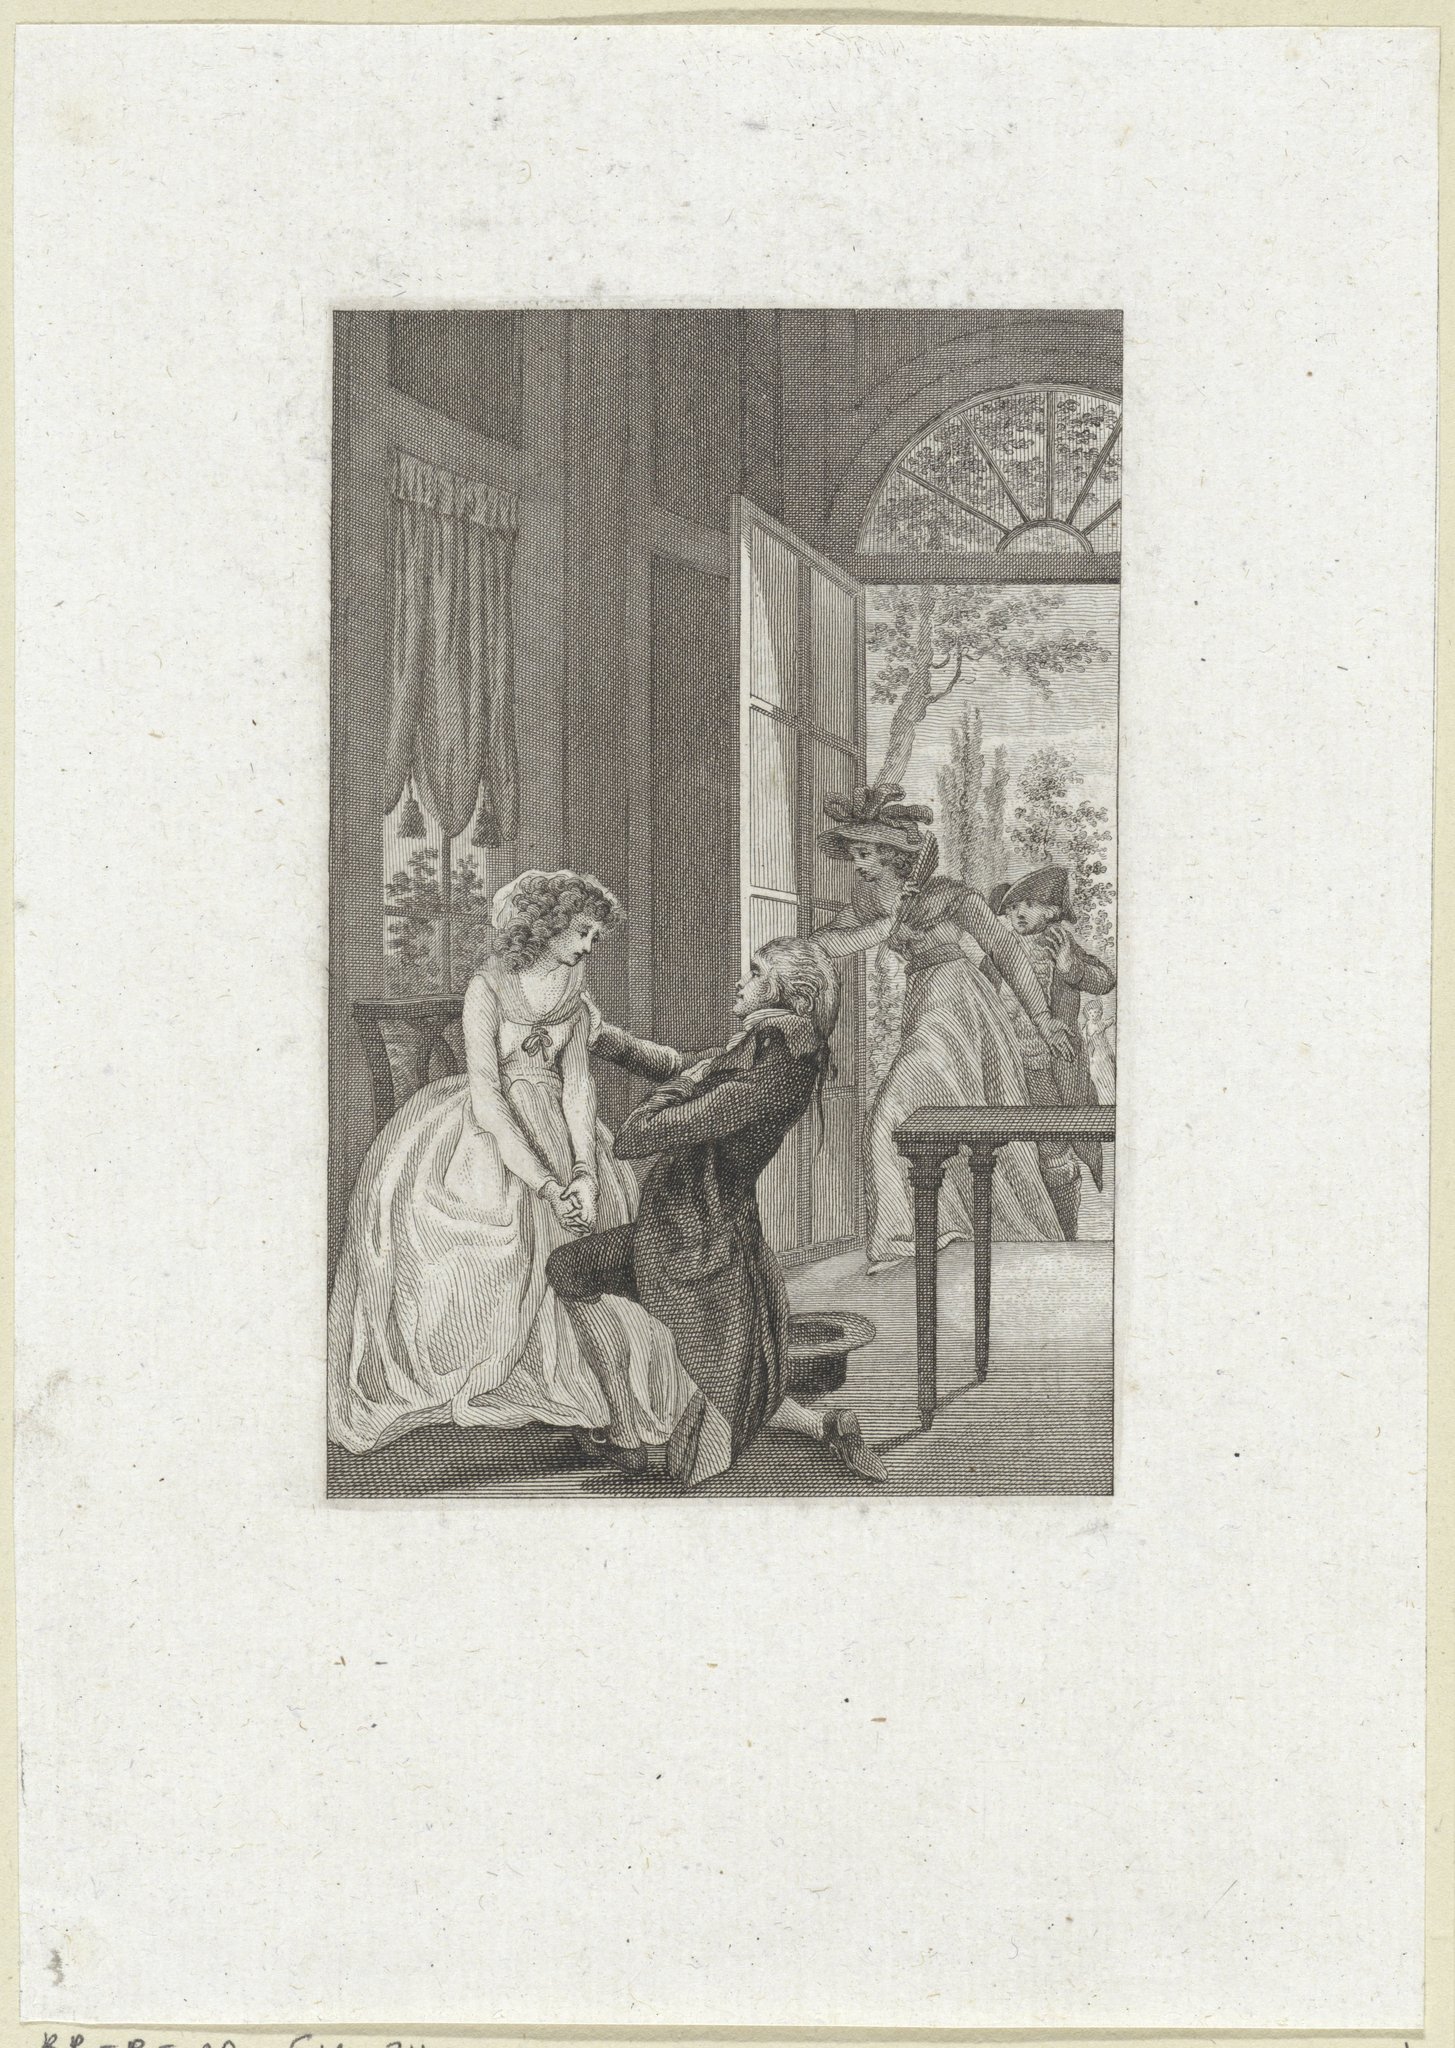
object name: print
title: Man doet een vrouw een aanzoek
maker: reinier vinkeles (i)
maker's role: draughtsman, print maker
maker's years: 1741-1816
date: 1798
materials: paper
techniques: engraving, etching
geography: amsterdam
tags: disturbers (~ wedding night) (+ variant), fan, man kneeling before his beloved (proposing)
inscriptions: collector's mark: Lugt 240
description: In een vertrek doet een man een vrouw een aanzoek terwijl er twee mensen binnen komen.